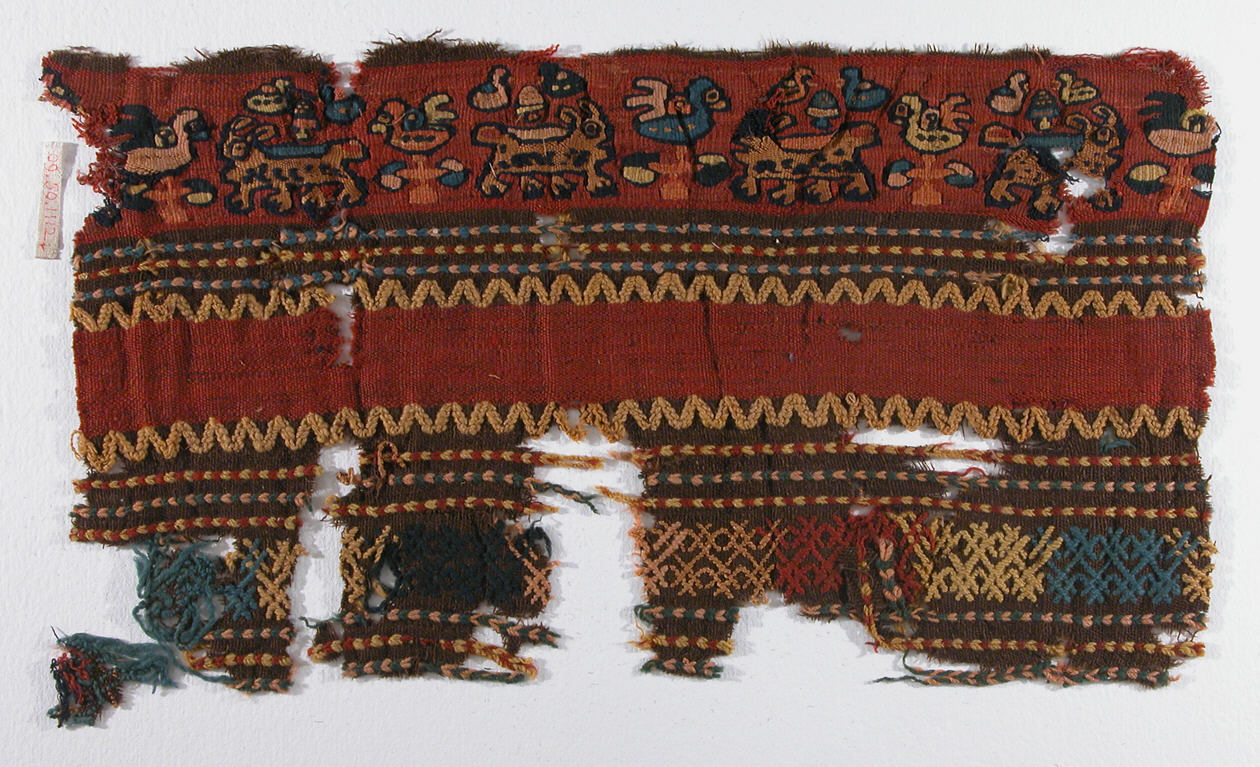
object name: band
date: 701-900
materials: wool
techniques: embroidery, weave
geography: egypt